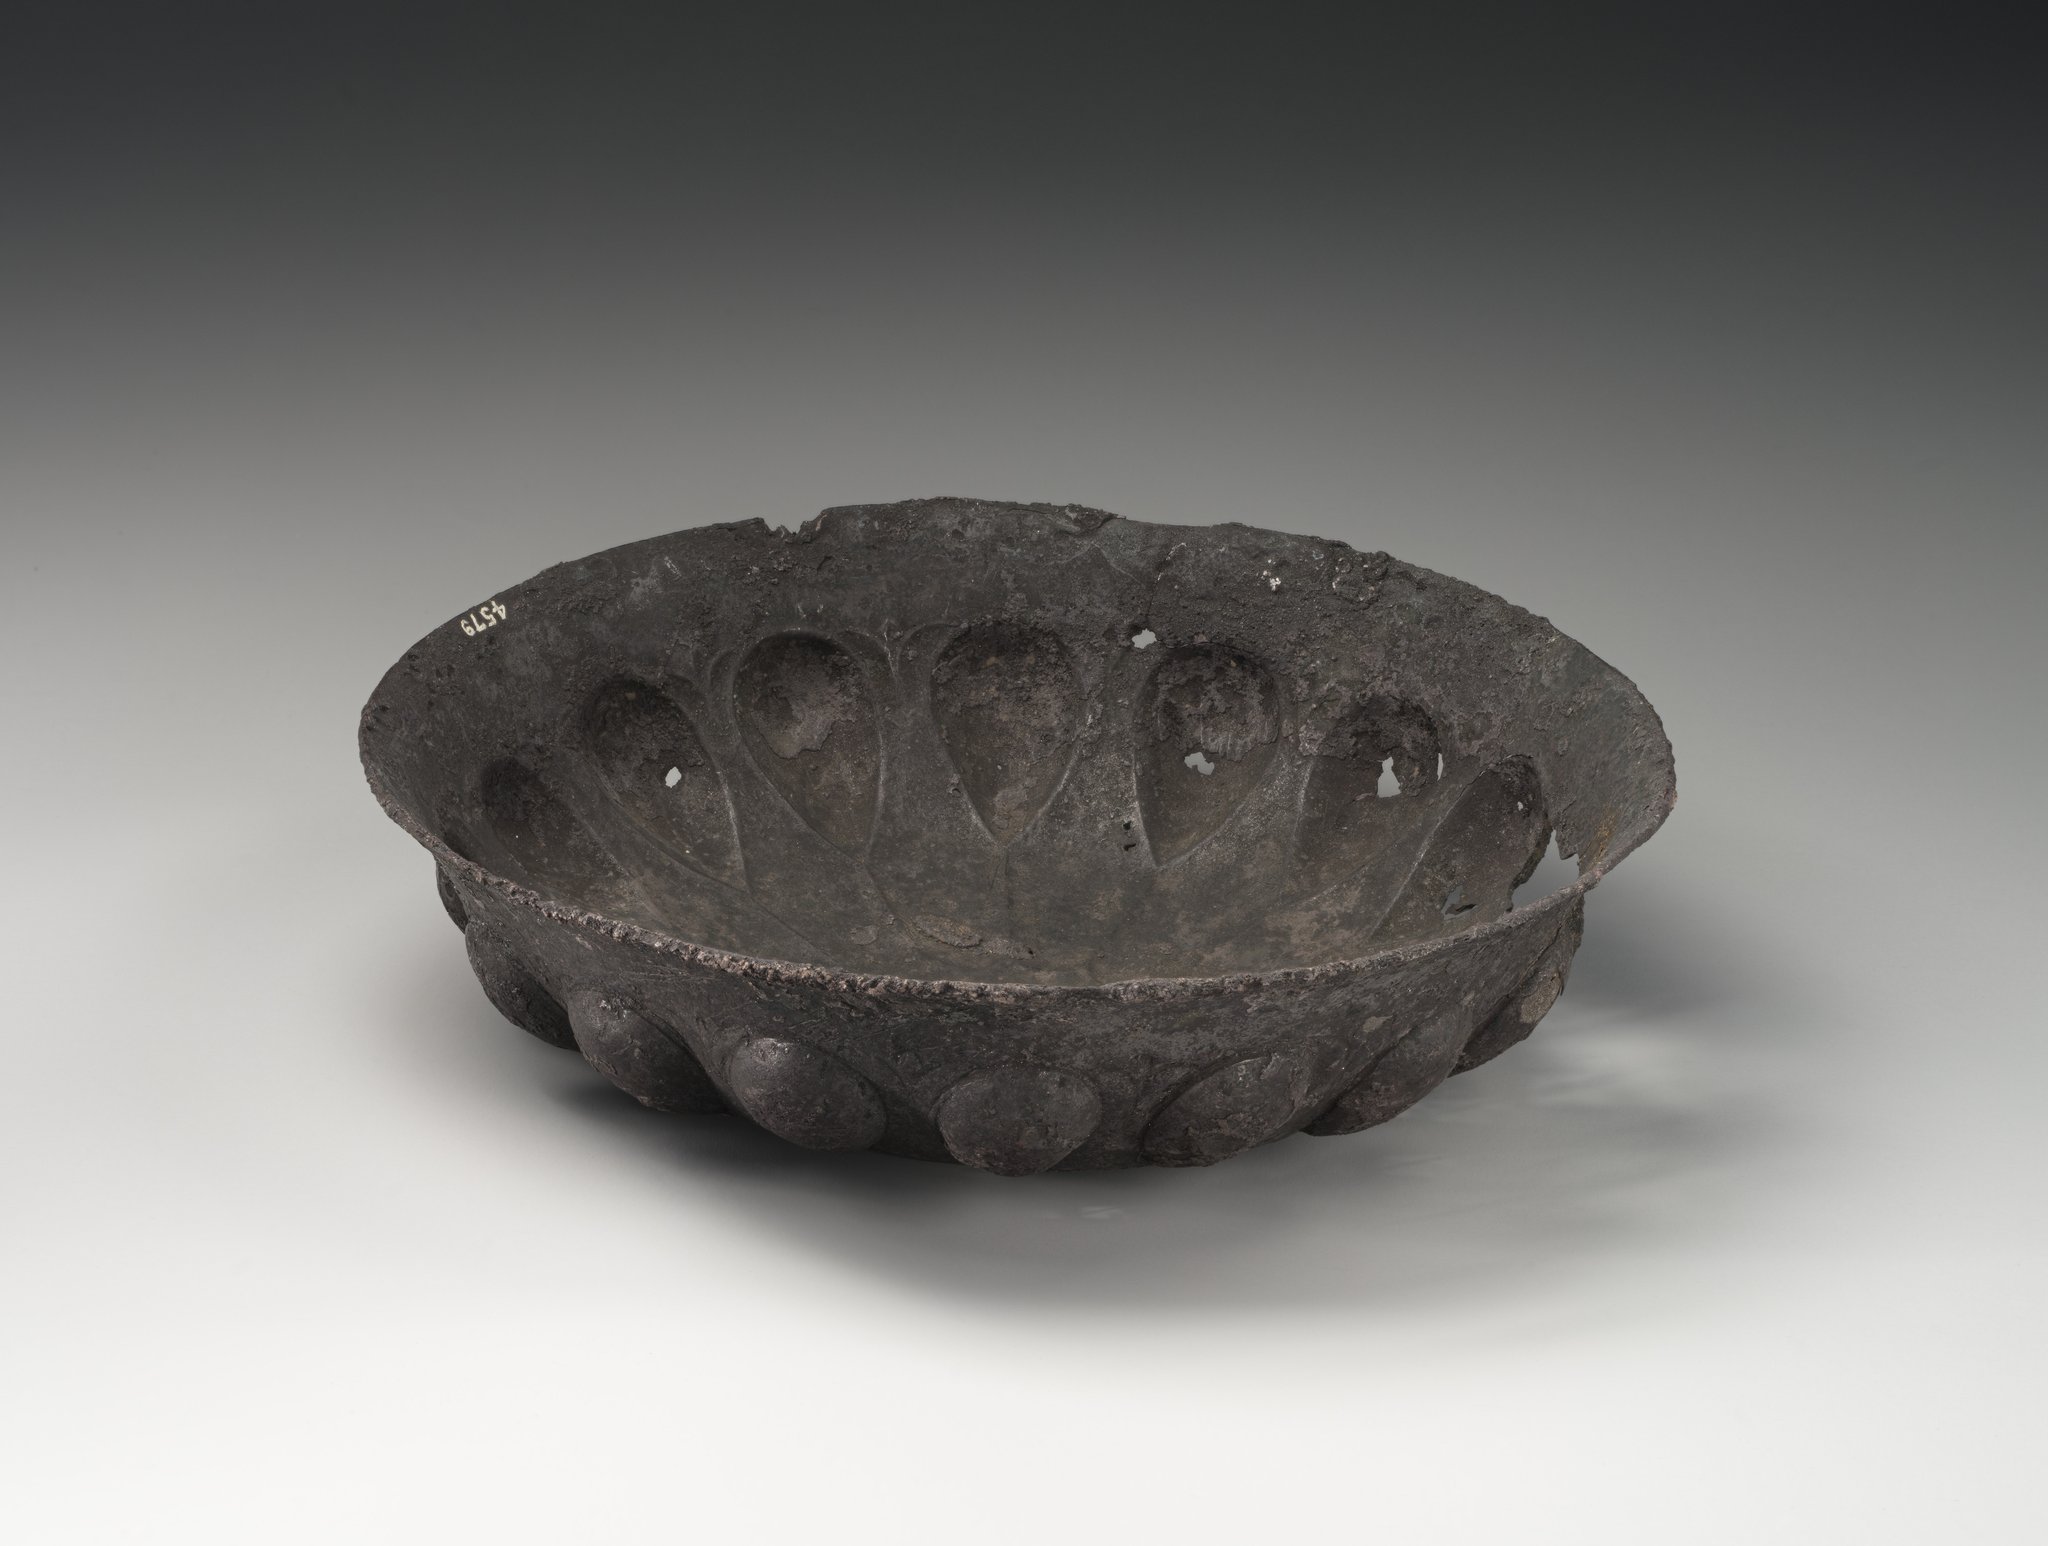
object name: patera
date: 7000 BCE-330 CE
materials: silver